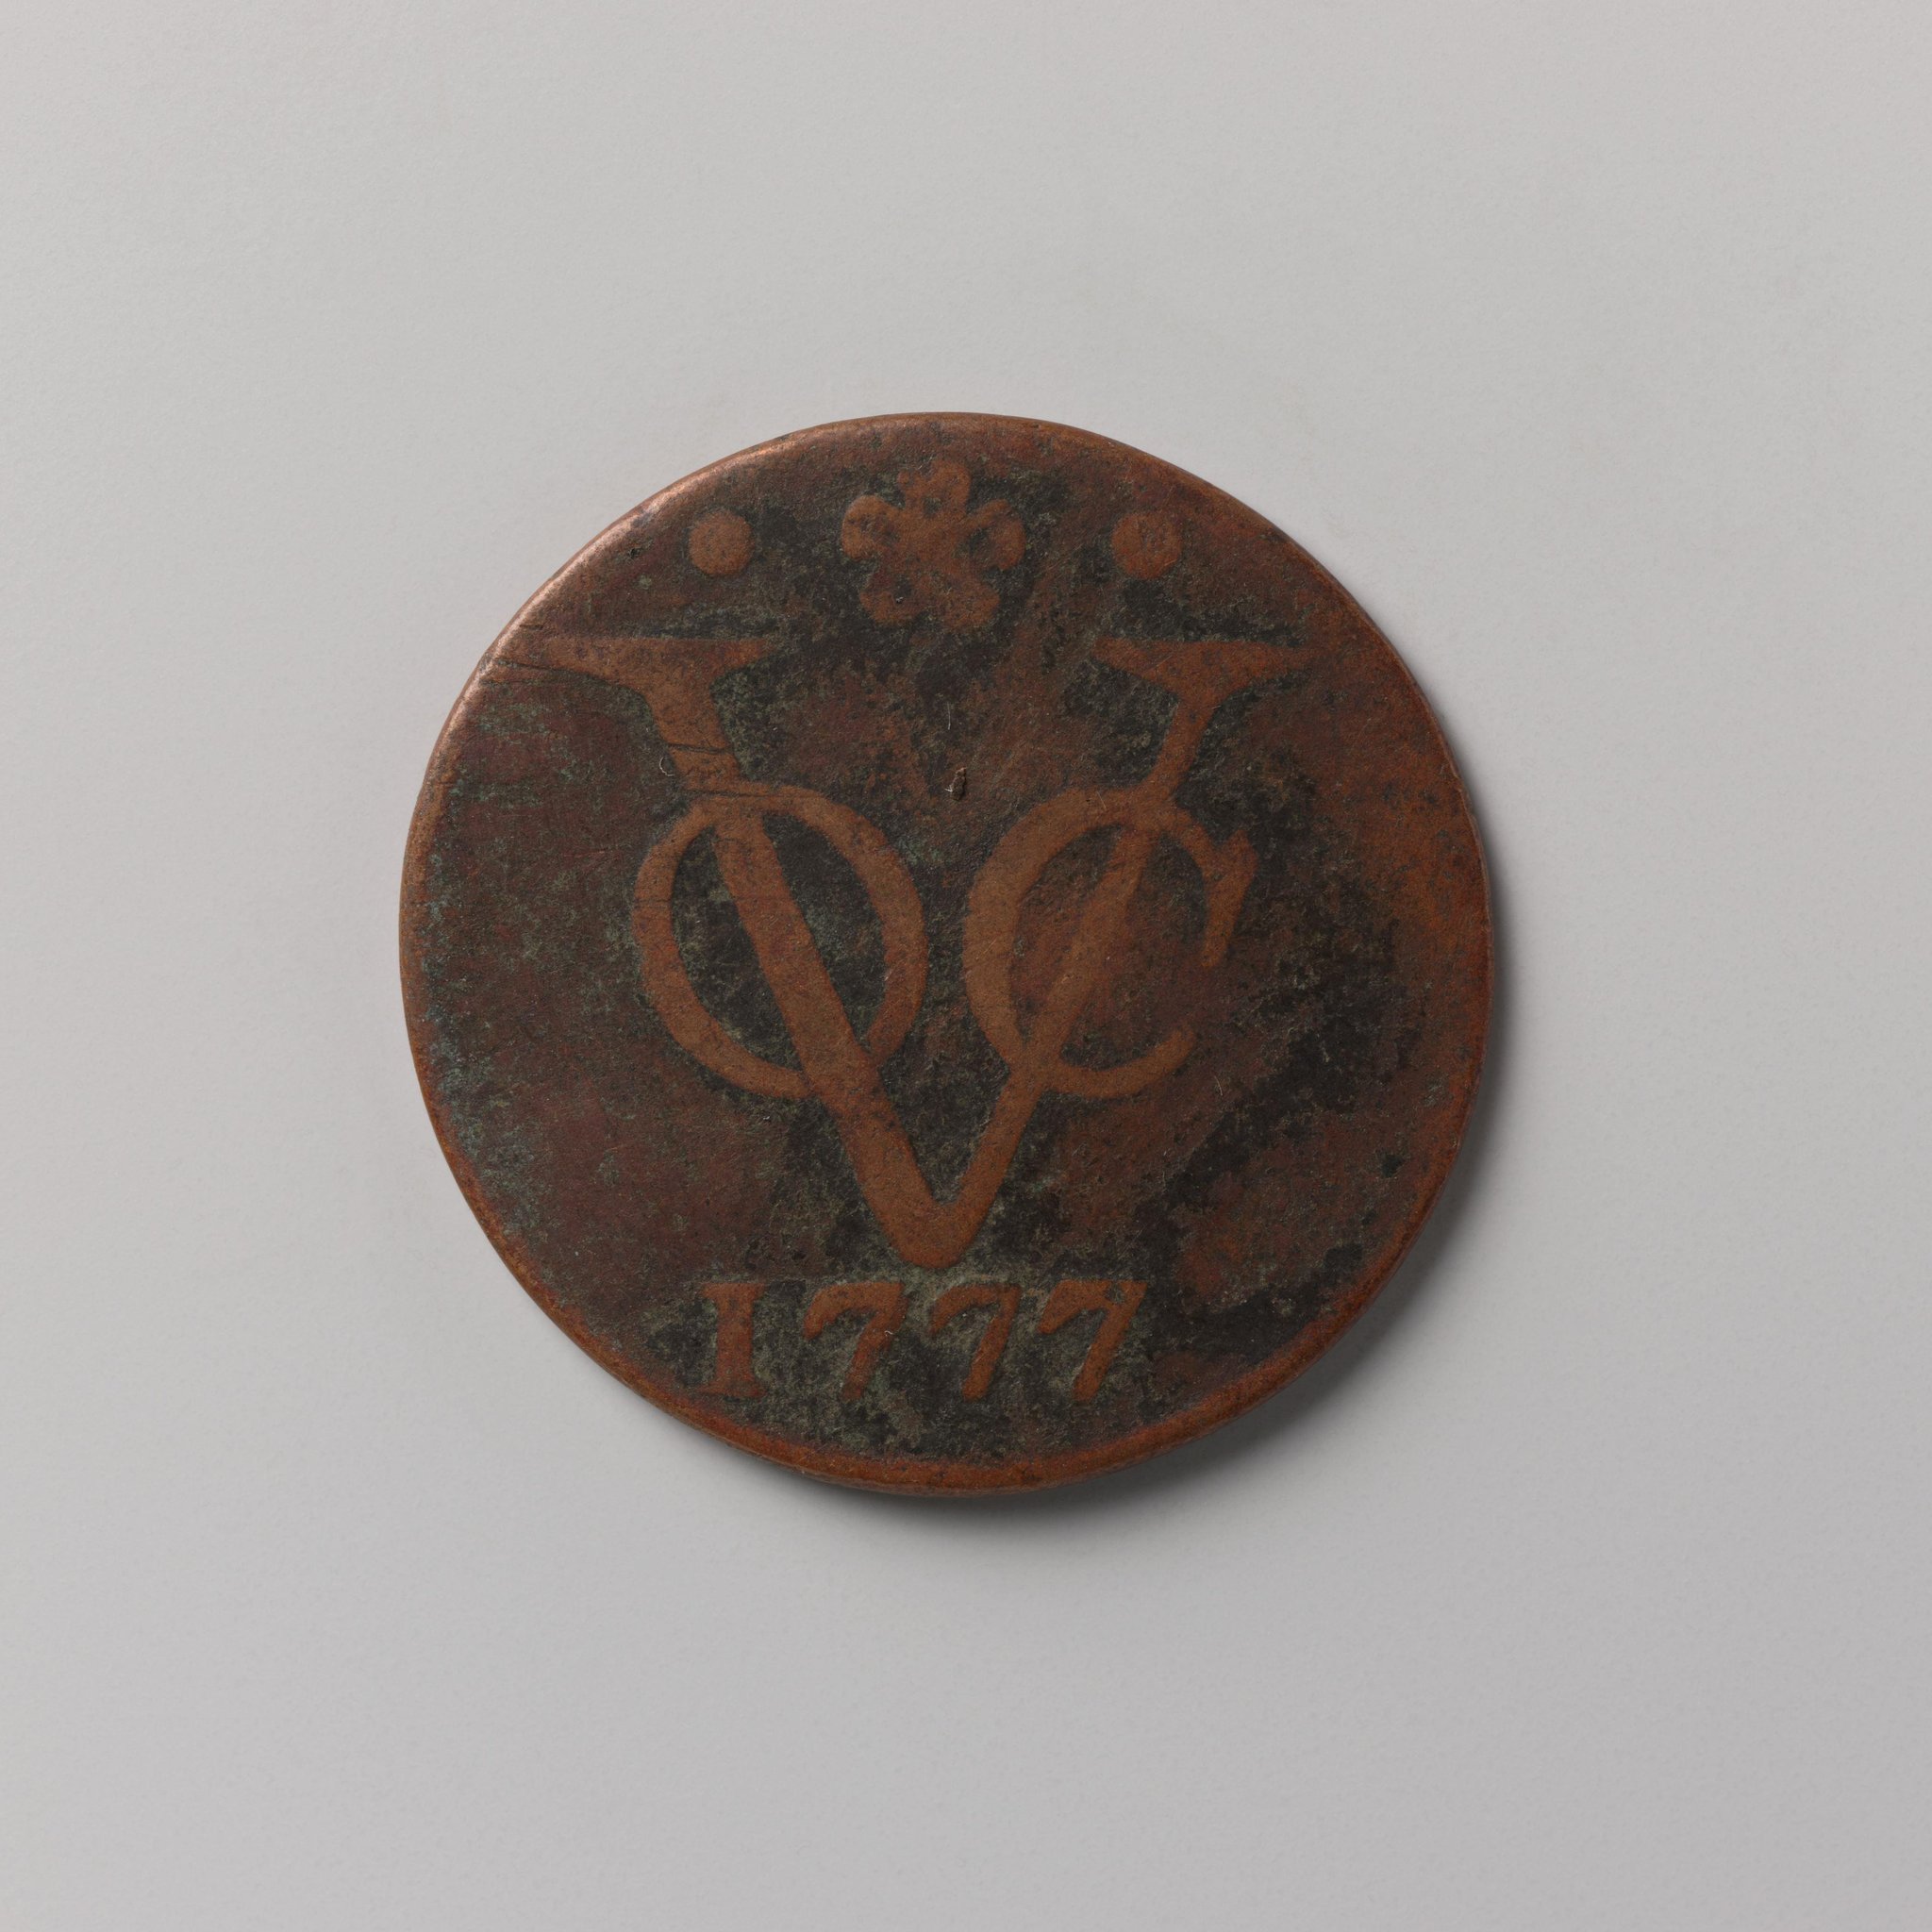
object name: coin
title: Duit van de VOC uit Holland, 1777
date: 1777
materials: copper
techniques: striking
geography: dordrecht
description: Koperen munt. Voorzijde: gekroond wapenschild van Holland. Keerzijde: monogram van de VOC, waarboven muntteken en waaronder jaartal. Gladde rand.